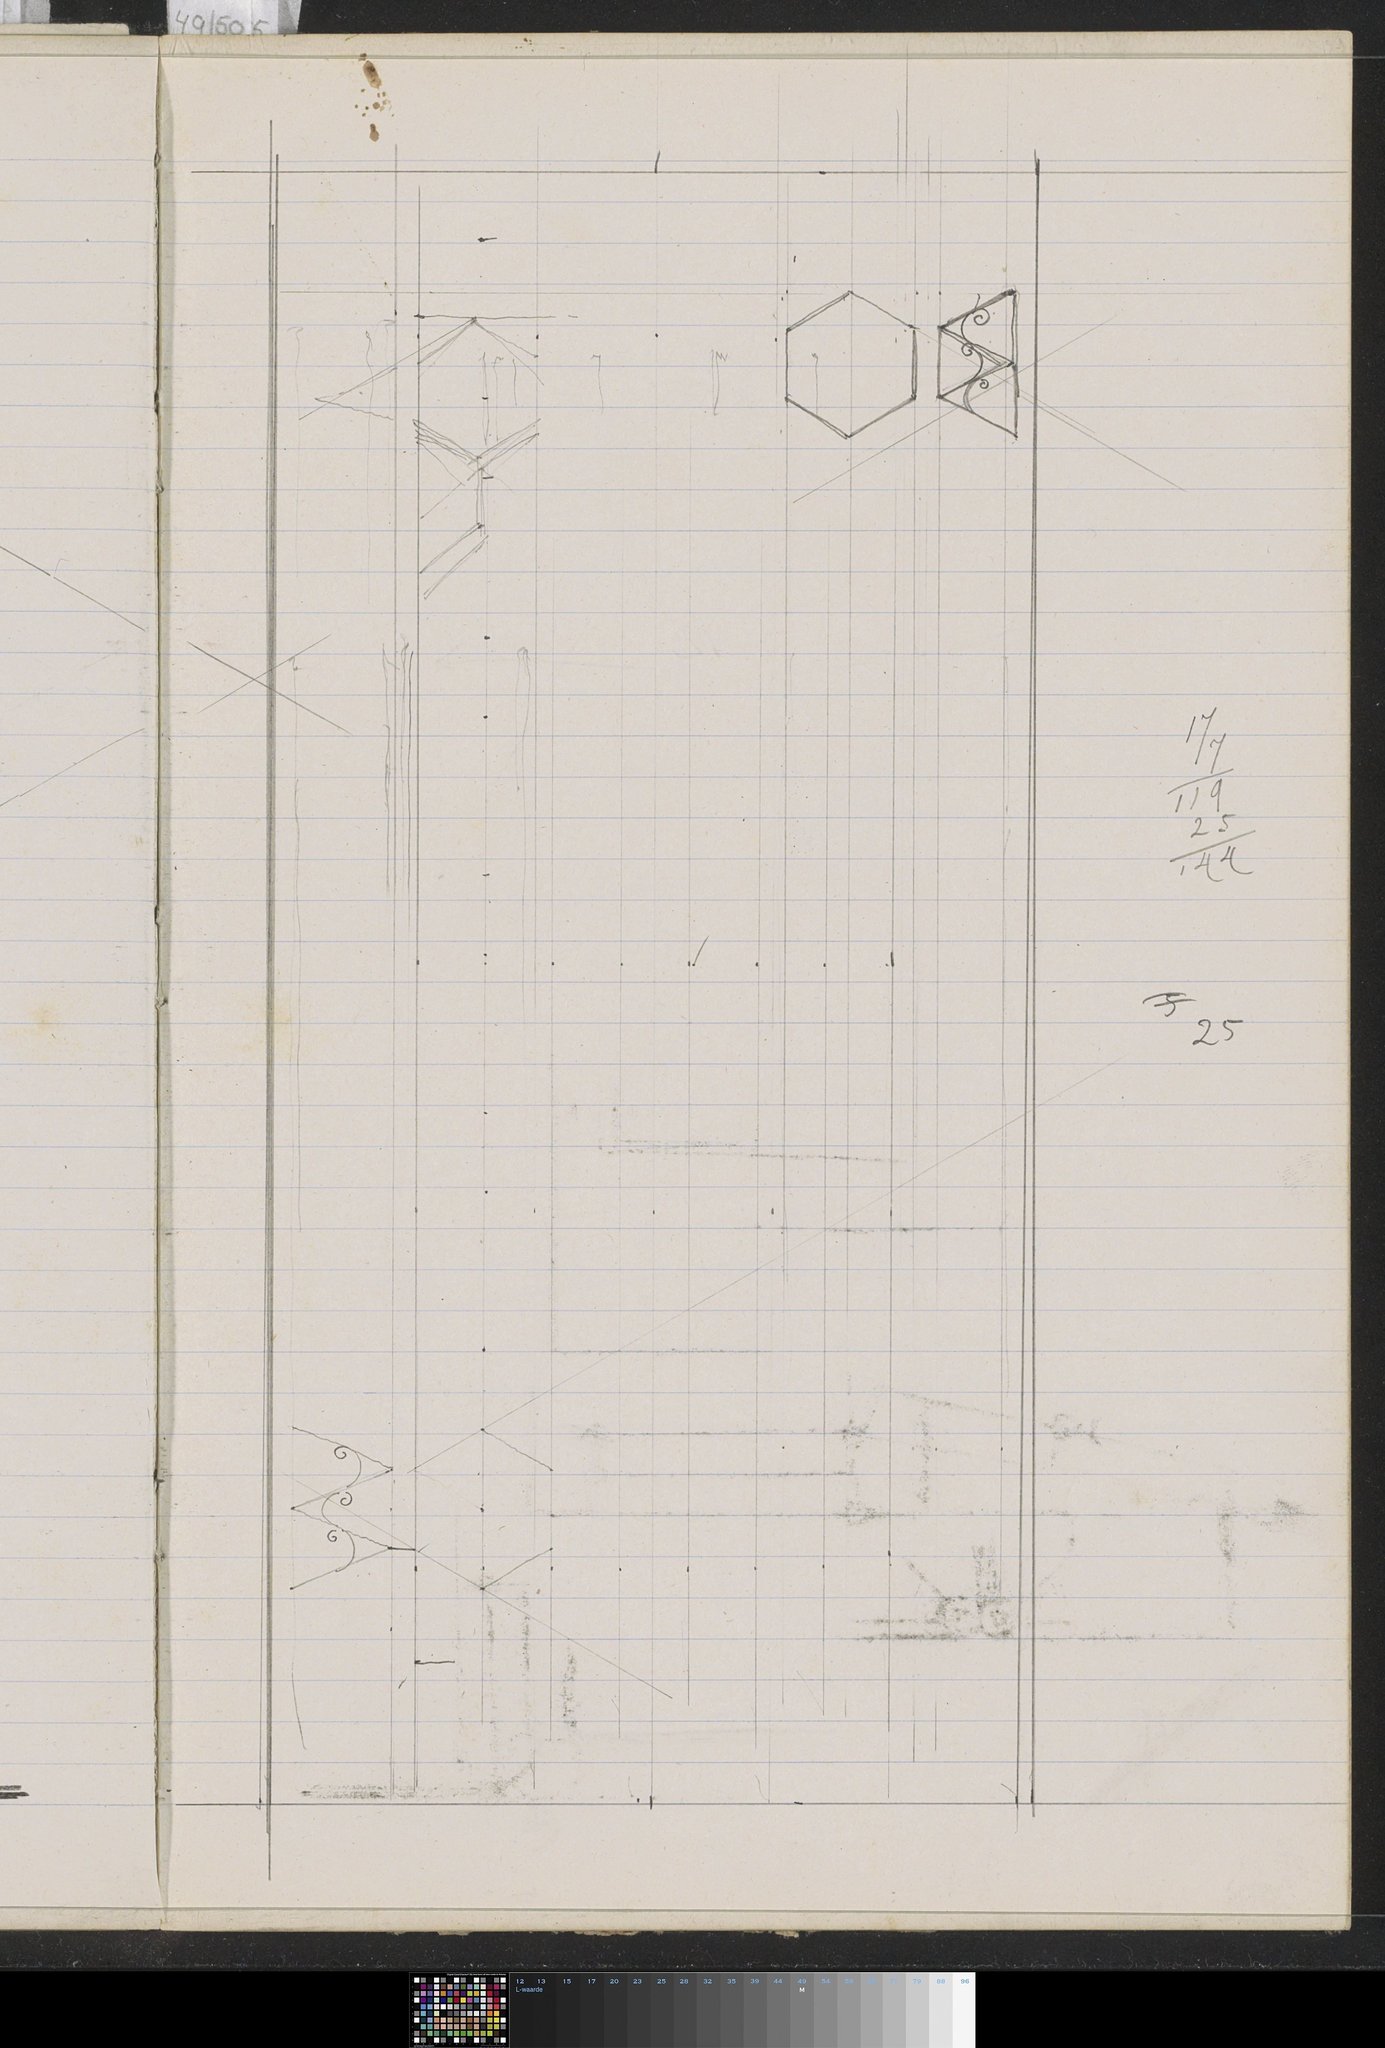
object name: sketchbook leaf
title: Studie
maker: gerrit willem dijsselhof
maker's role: designer, draughtsman, print maker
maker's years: 1866-1924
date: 1901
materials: pencil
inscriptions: annotation: ‘[...]’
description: Blad 47 recto uit een schetsboek met 79 bladen.